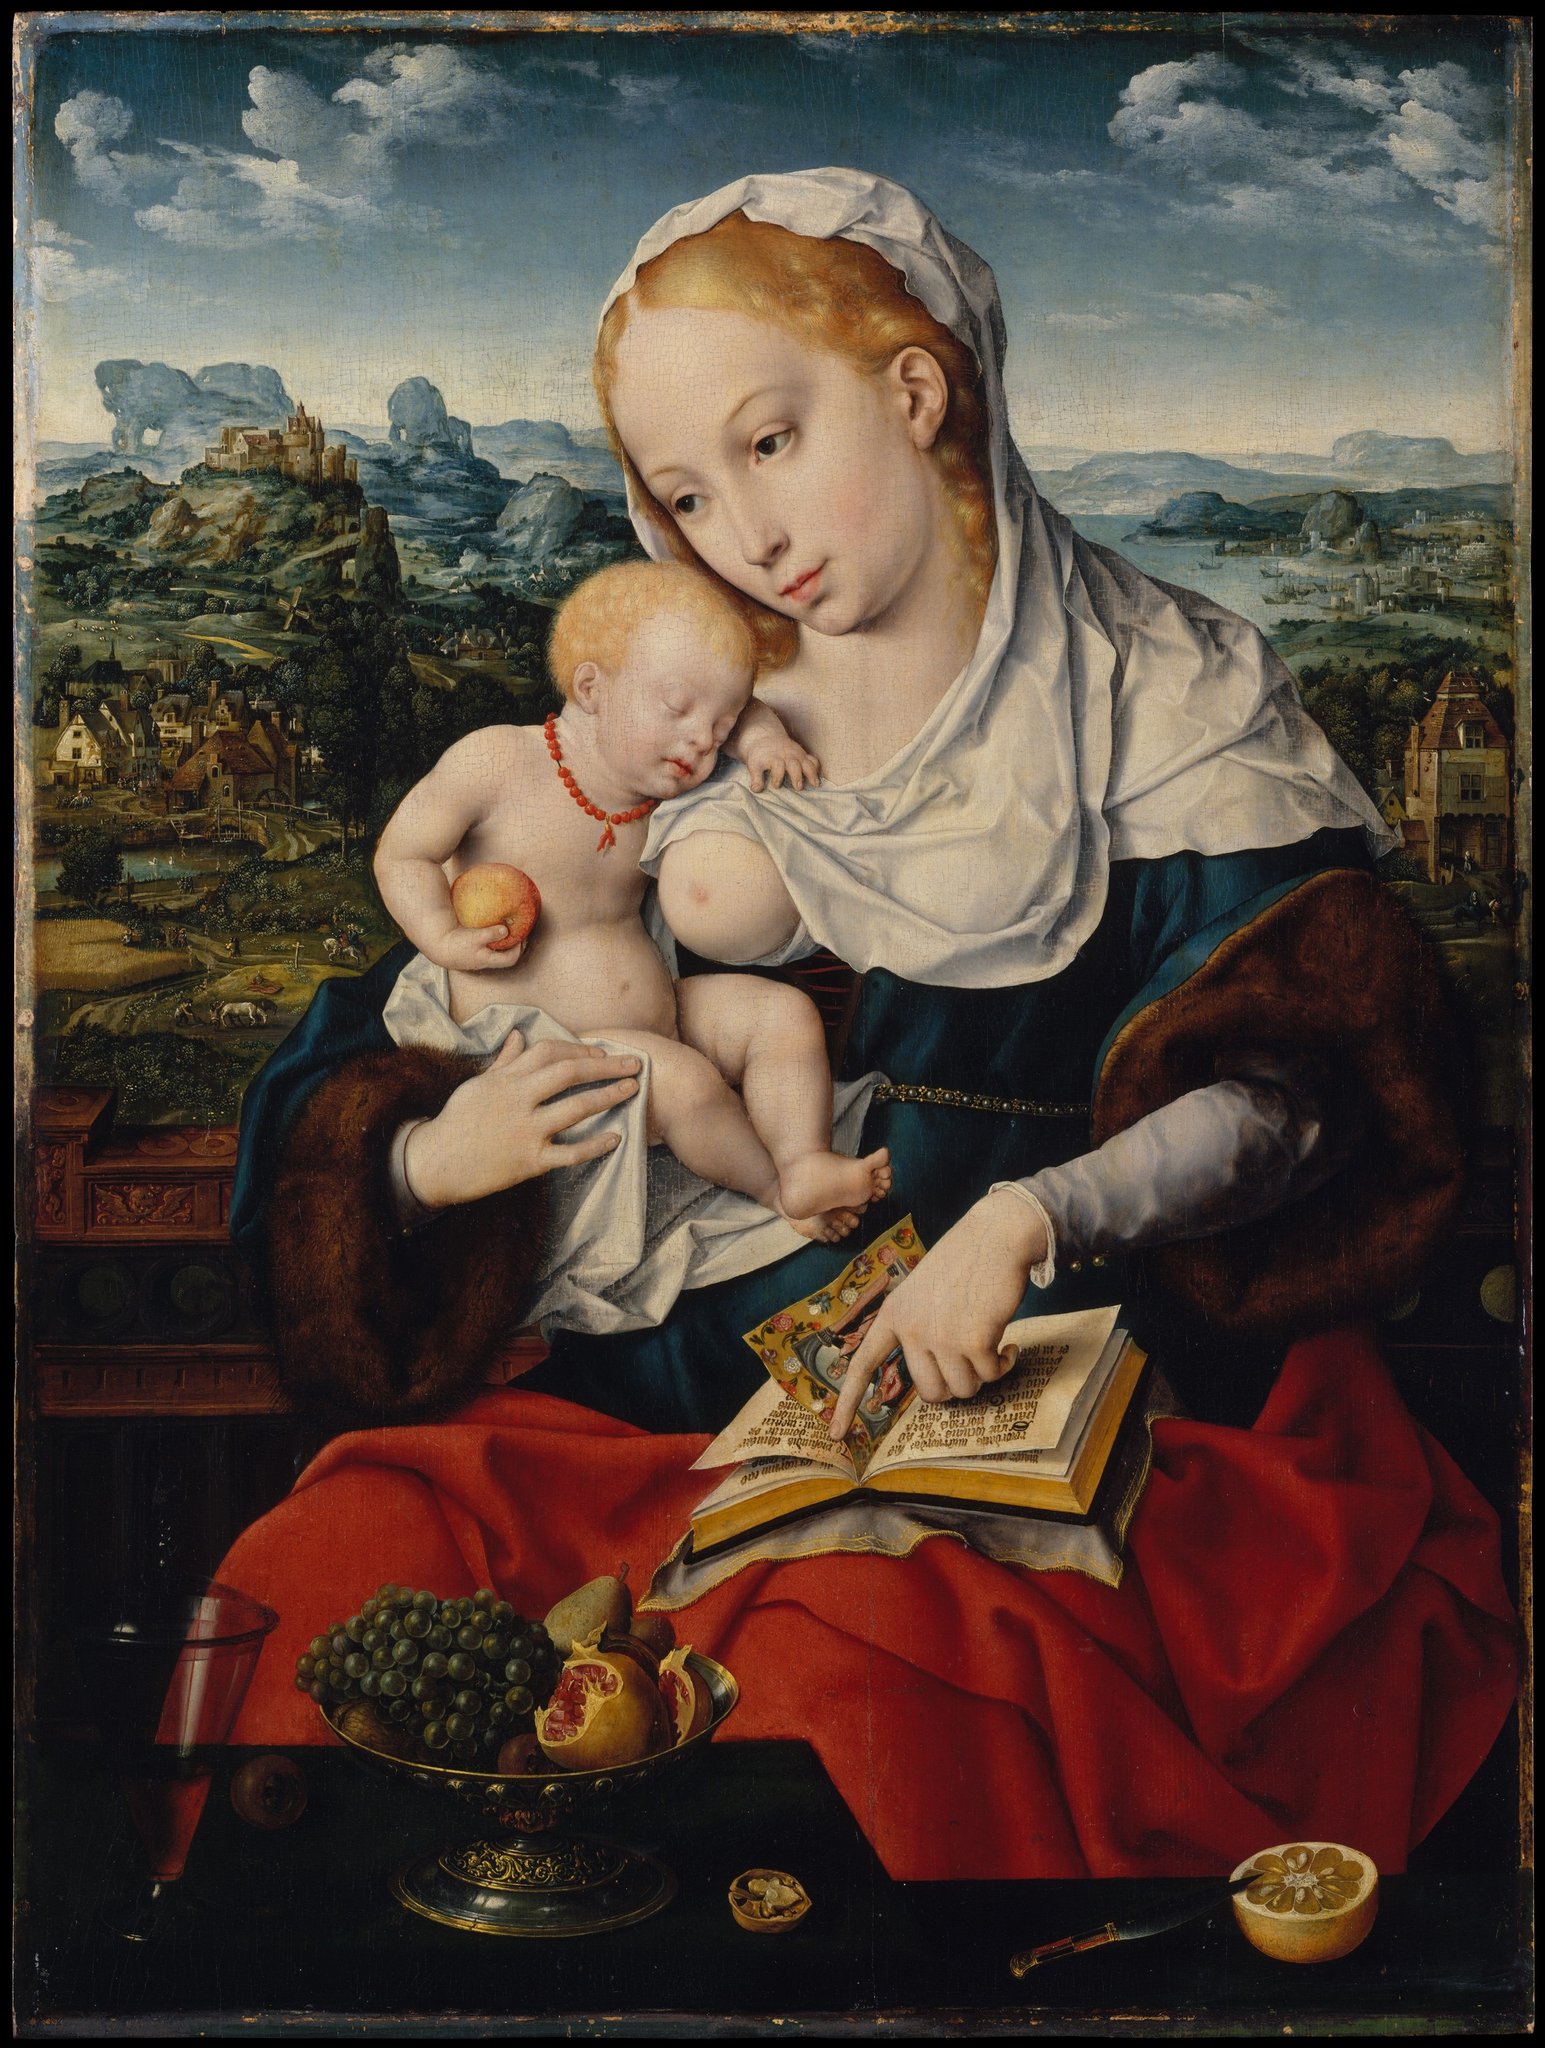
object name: painting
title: Virgin and Child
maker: joos van cleve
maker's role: artist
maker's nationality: netherlandish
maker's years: 1485-1541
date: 1525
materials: oil, wood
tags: fruit,apples,grapes,madonna and child,nursing